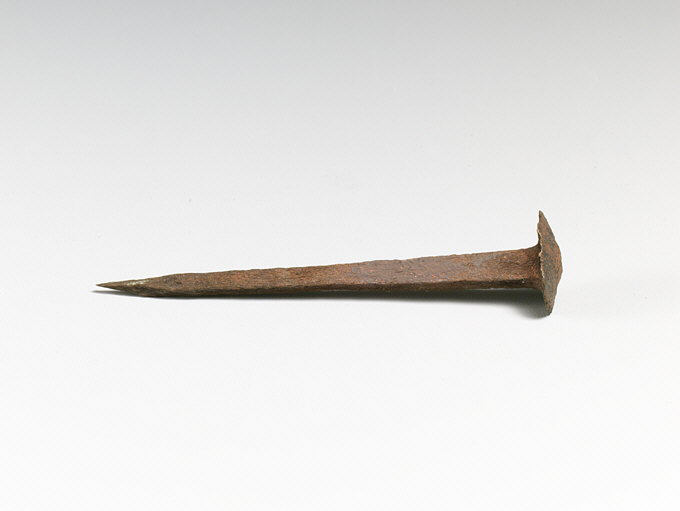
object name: nail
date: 7000 BCE-330 CE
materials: bronze